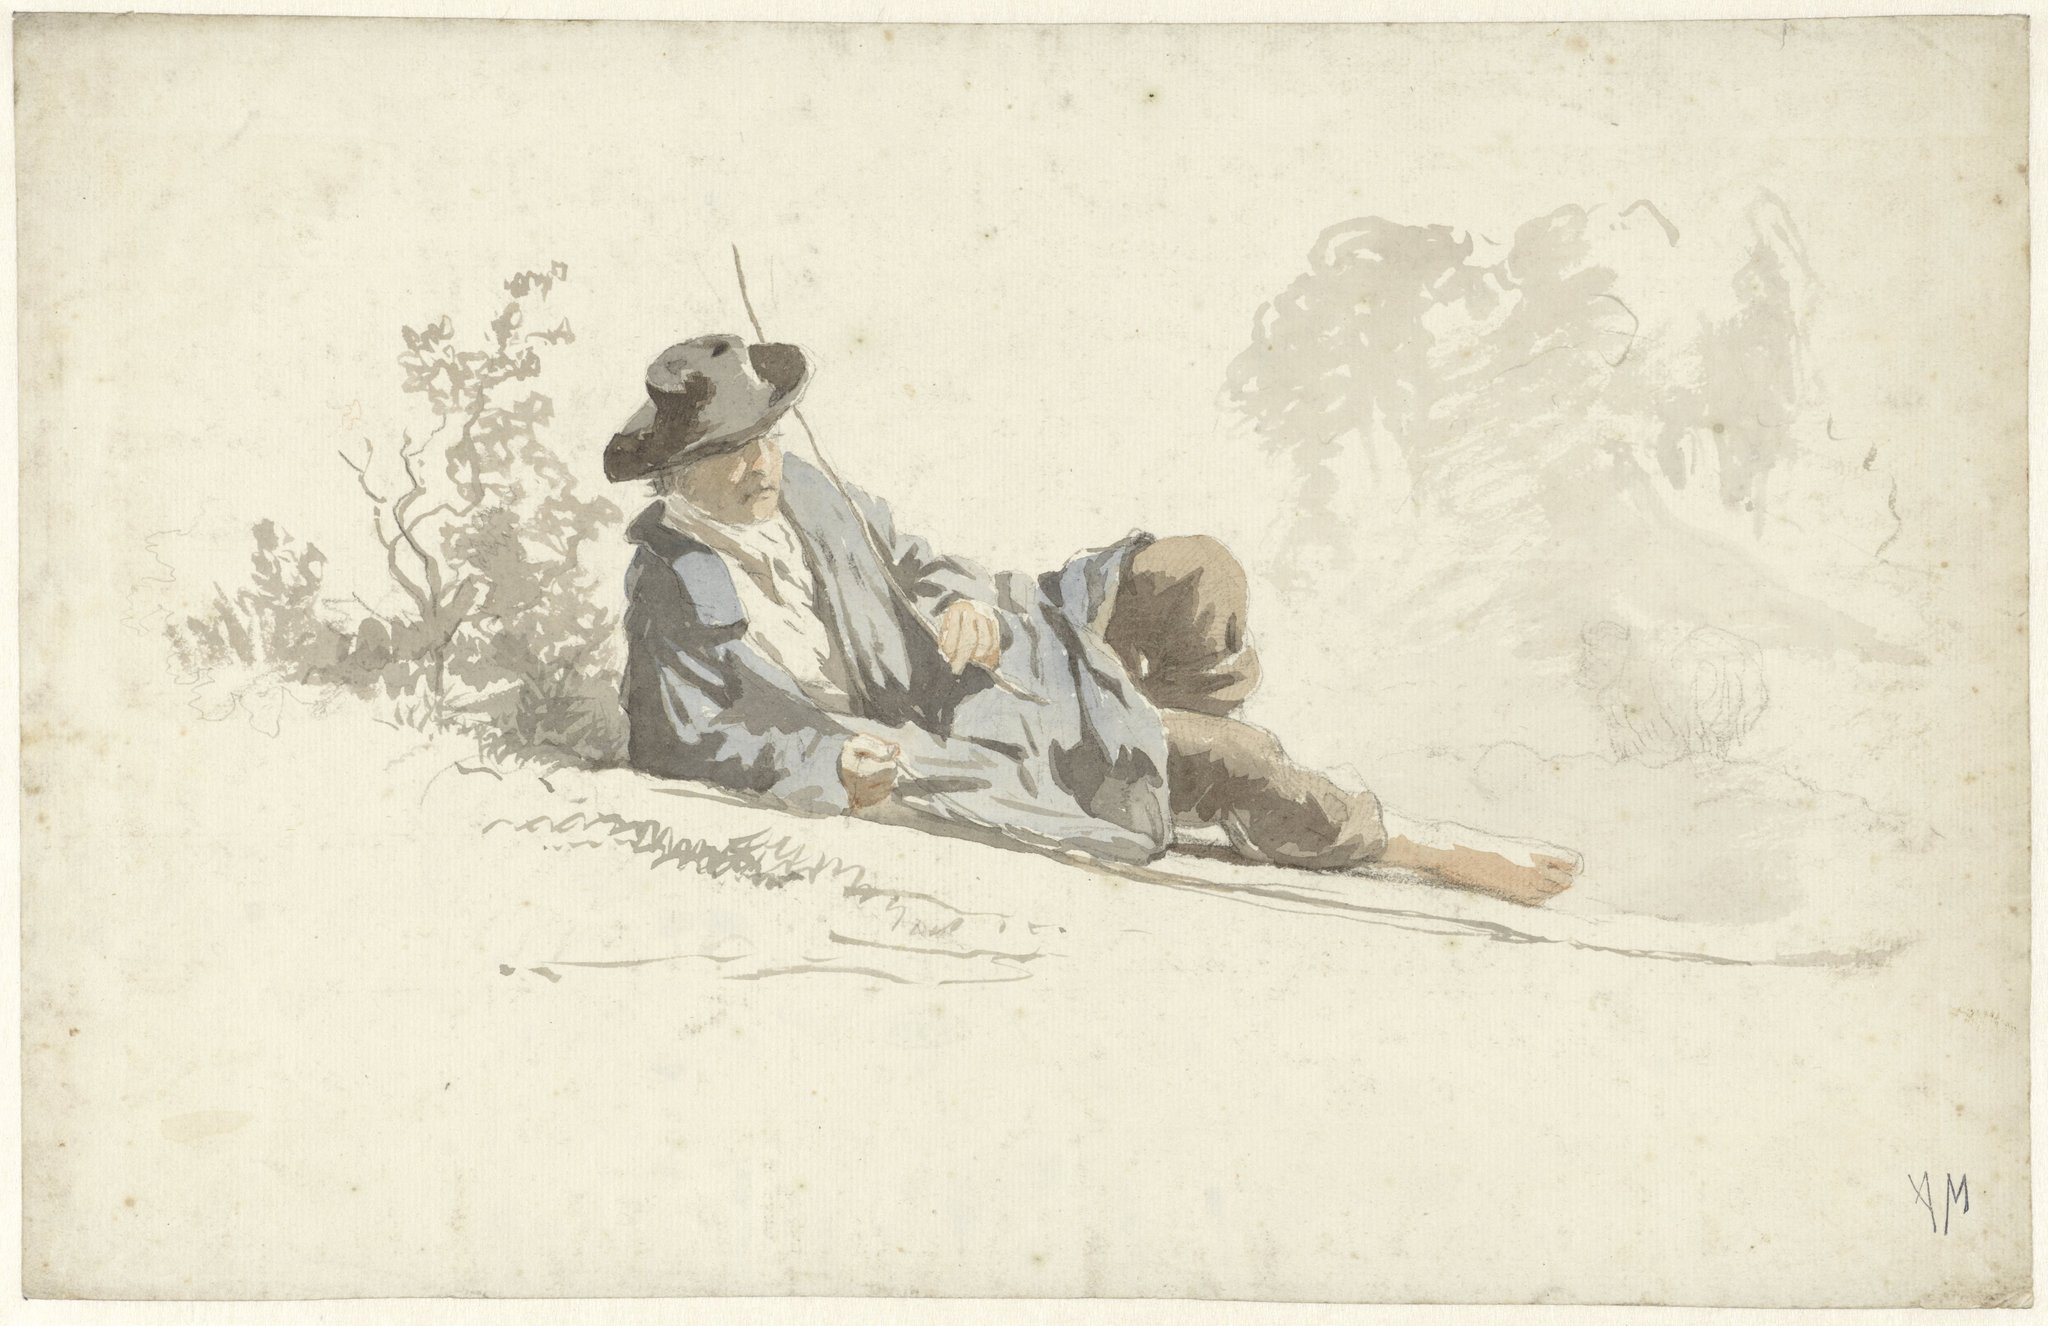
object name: drawing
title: Op de grond liggende, rustende man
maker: anton mauve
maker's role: draughtsman, painter, print maker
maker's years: 1838-1888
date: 1848-1888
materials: chalk, paper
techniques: brush